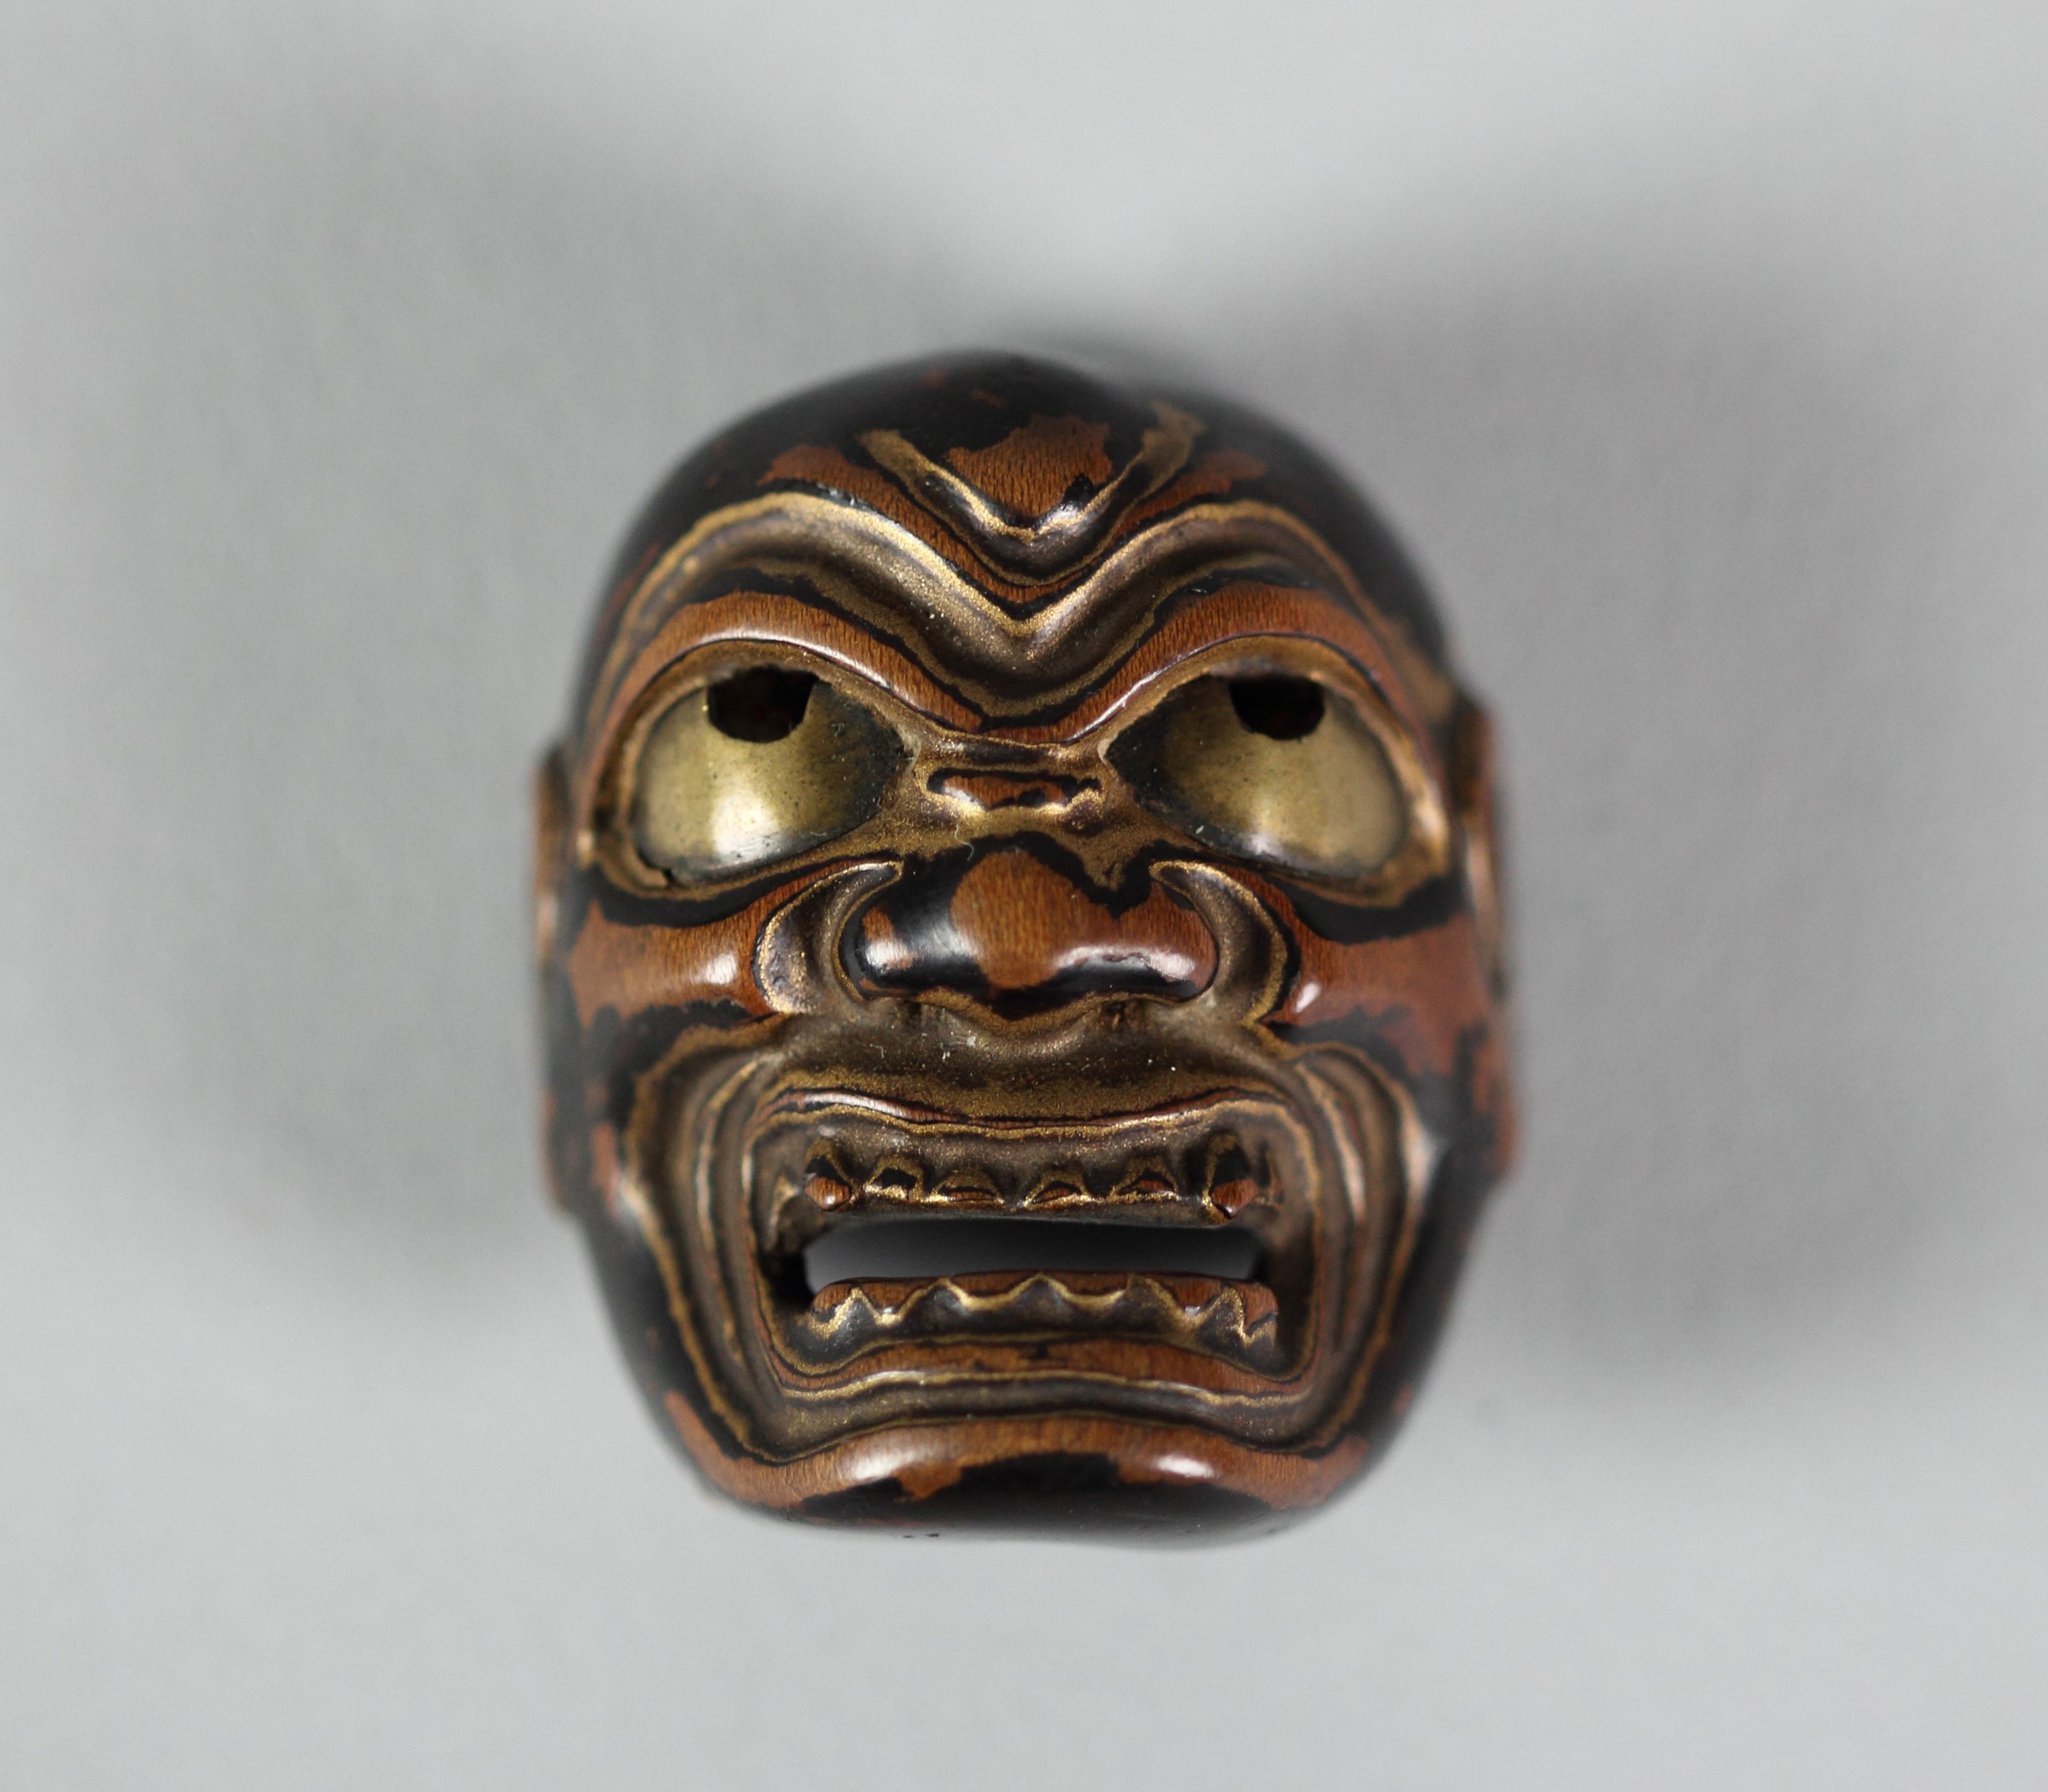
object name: netsuke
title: Noh Mask: Ō-Tobide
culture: japanese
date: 1767-1833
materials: gold, wood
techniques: lacquer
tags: masks